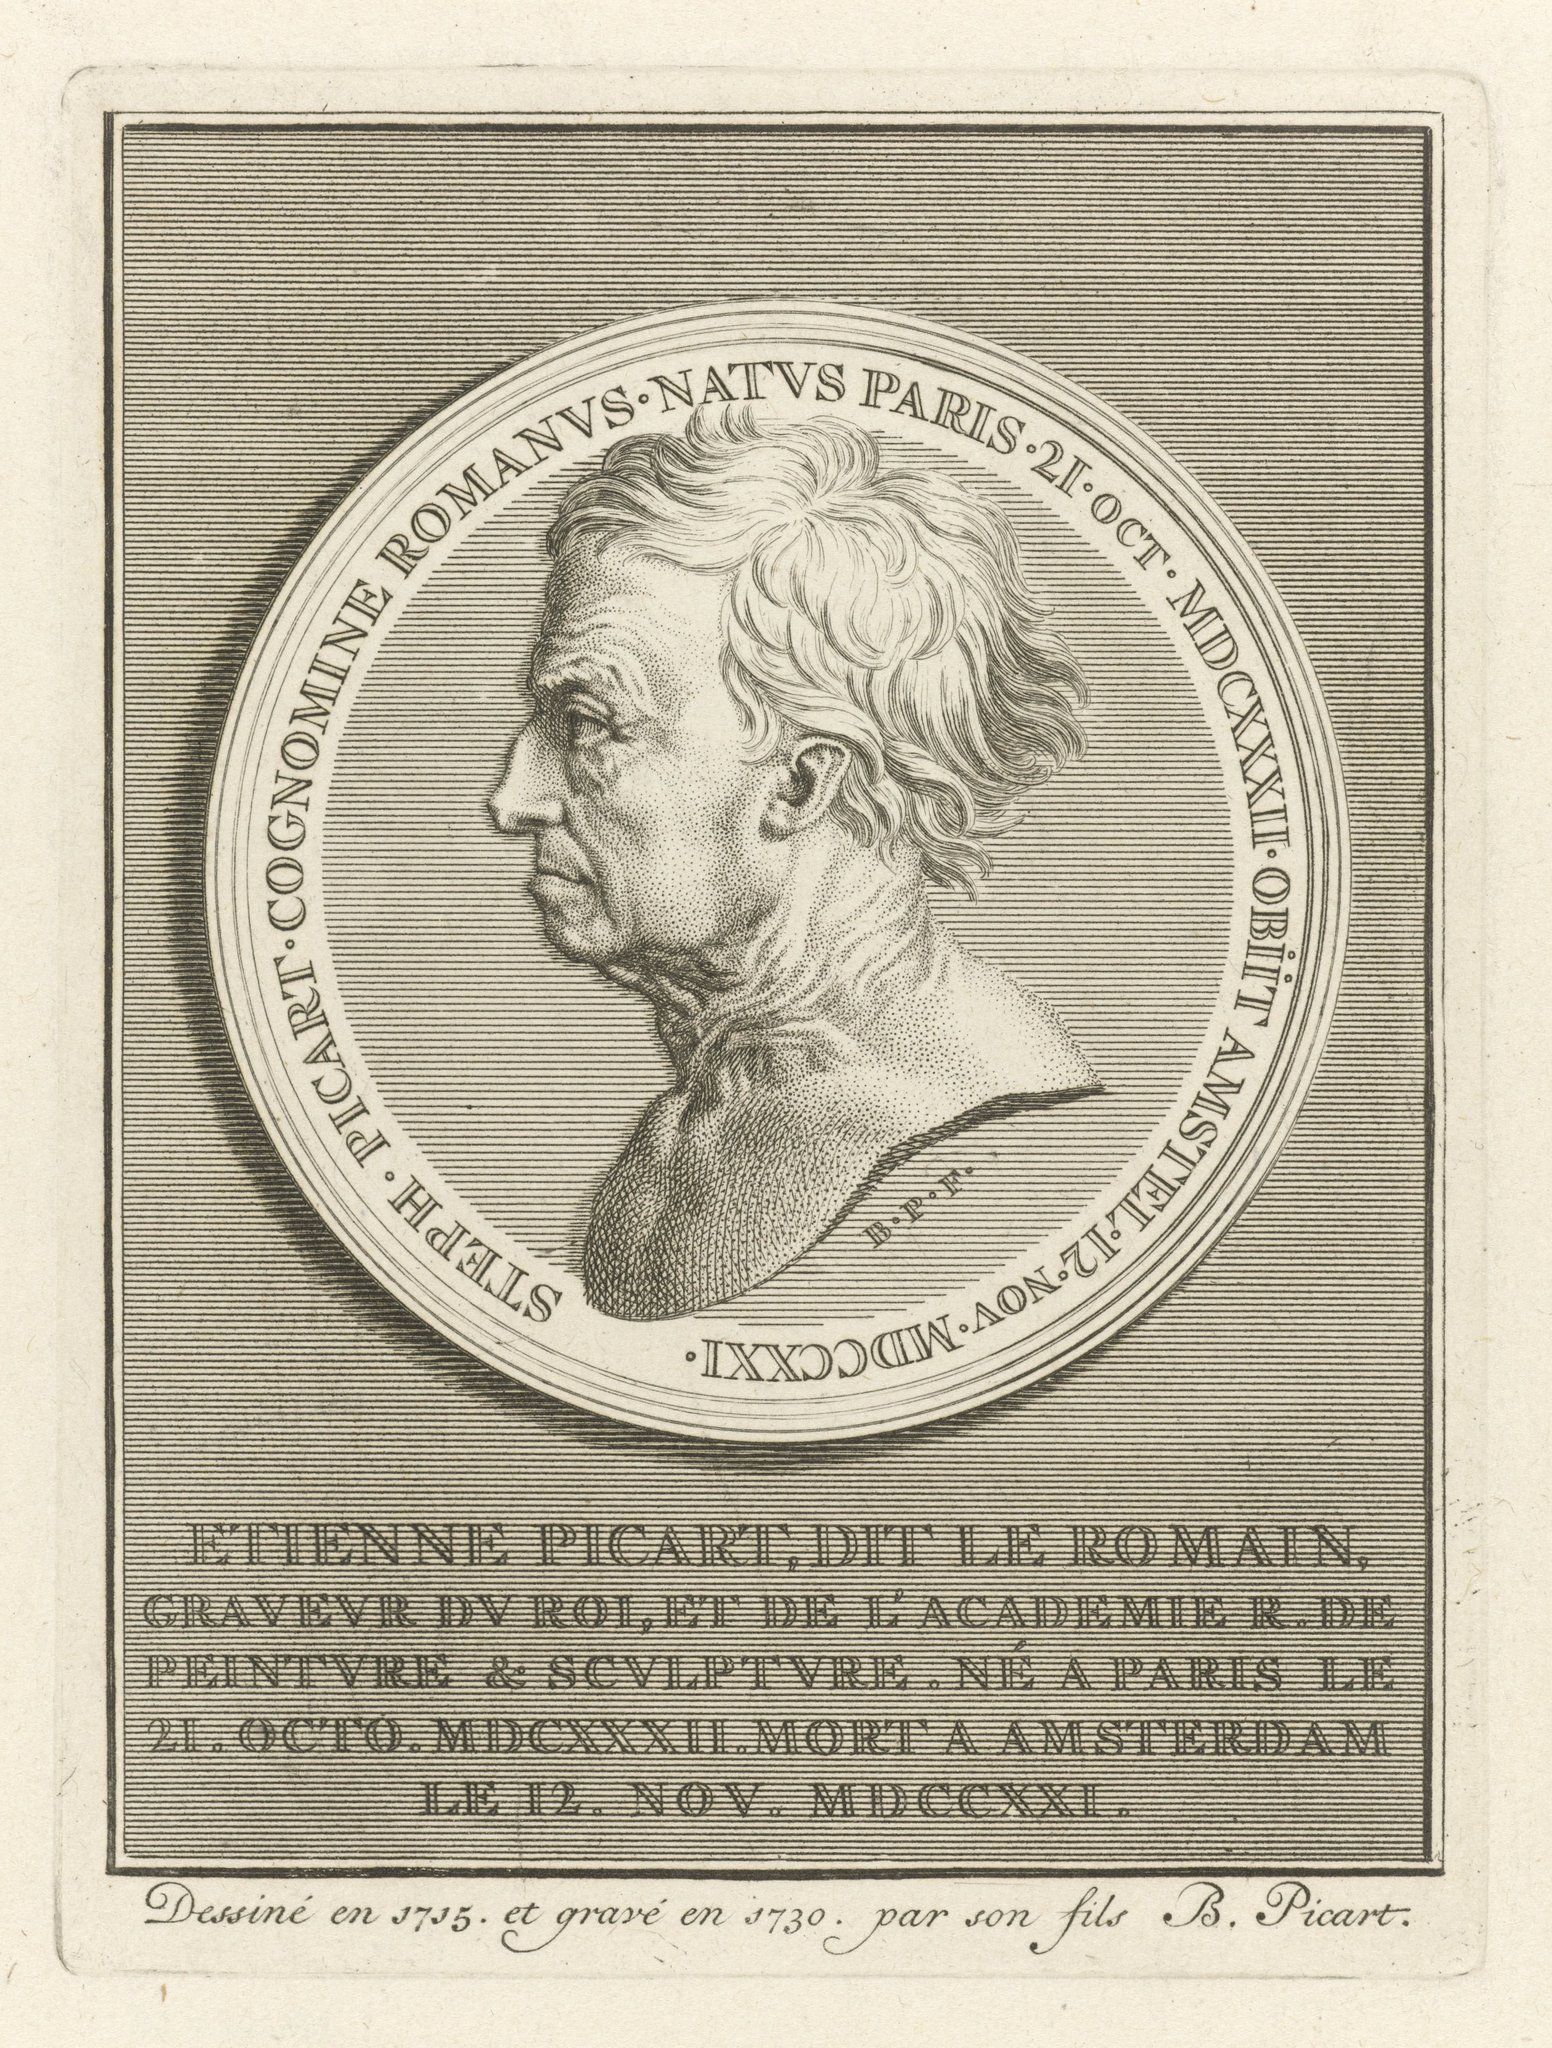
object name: print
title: Medaillon met het portret van Etienne Picart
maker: bernard picart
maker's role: draughtsman, print maker, publisher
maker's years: 1673-1733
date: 1730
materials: paper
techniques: engraving, etching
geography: amsterdam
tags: etienne picart, historical persons, portrait, self-portrait of graphic artist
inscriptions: collector's mark: Lugt 2228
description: Medaillon met het portret van Etienne (Stephanus) Picart, ook wel 'de Romein' genoemd. Hij is de vader van de kunstenaar. In de marge een vijfregelig onderschrift in het Frans.